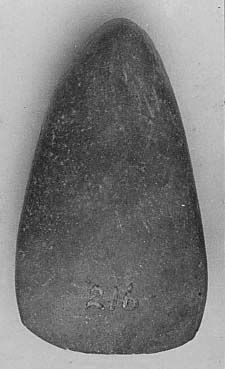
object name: hatchet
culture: french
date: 1902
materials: jade